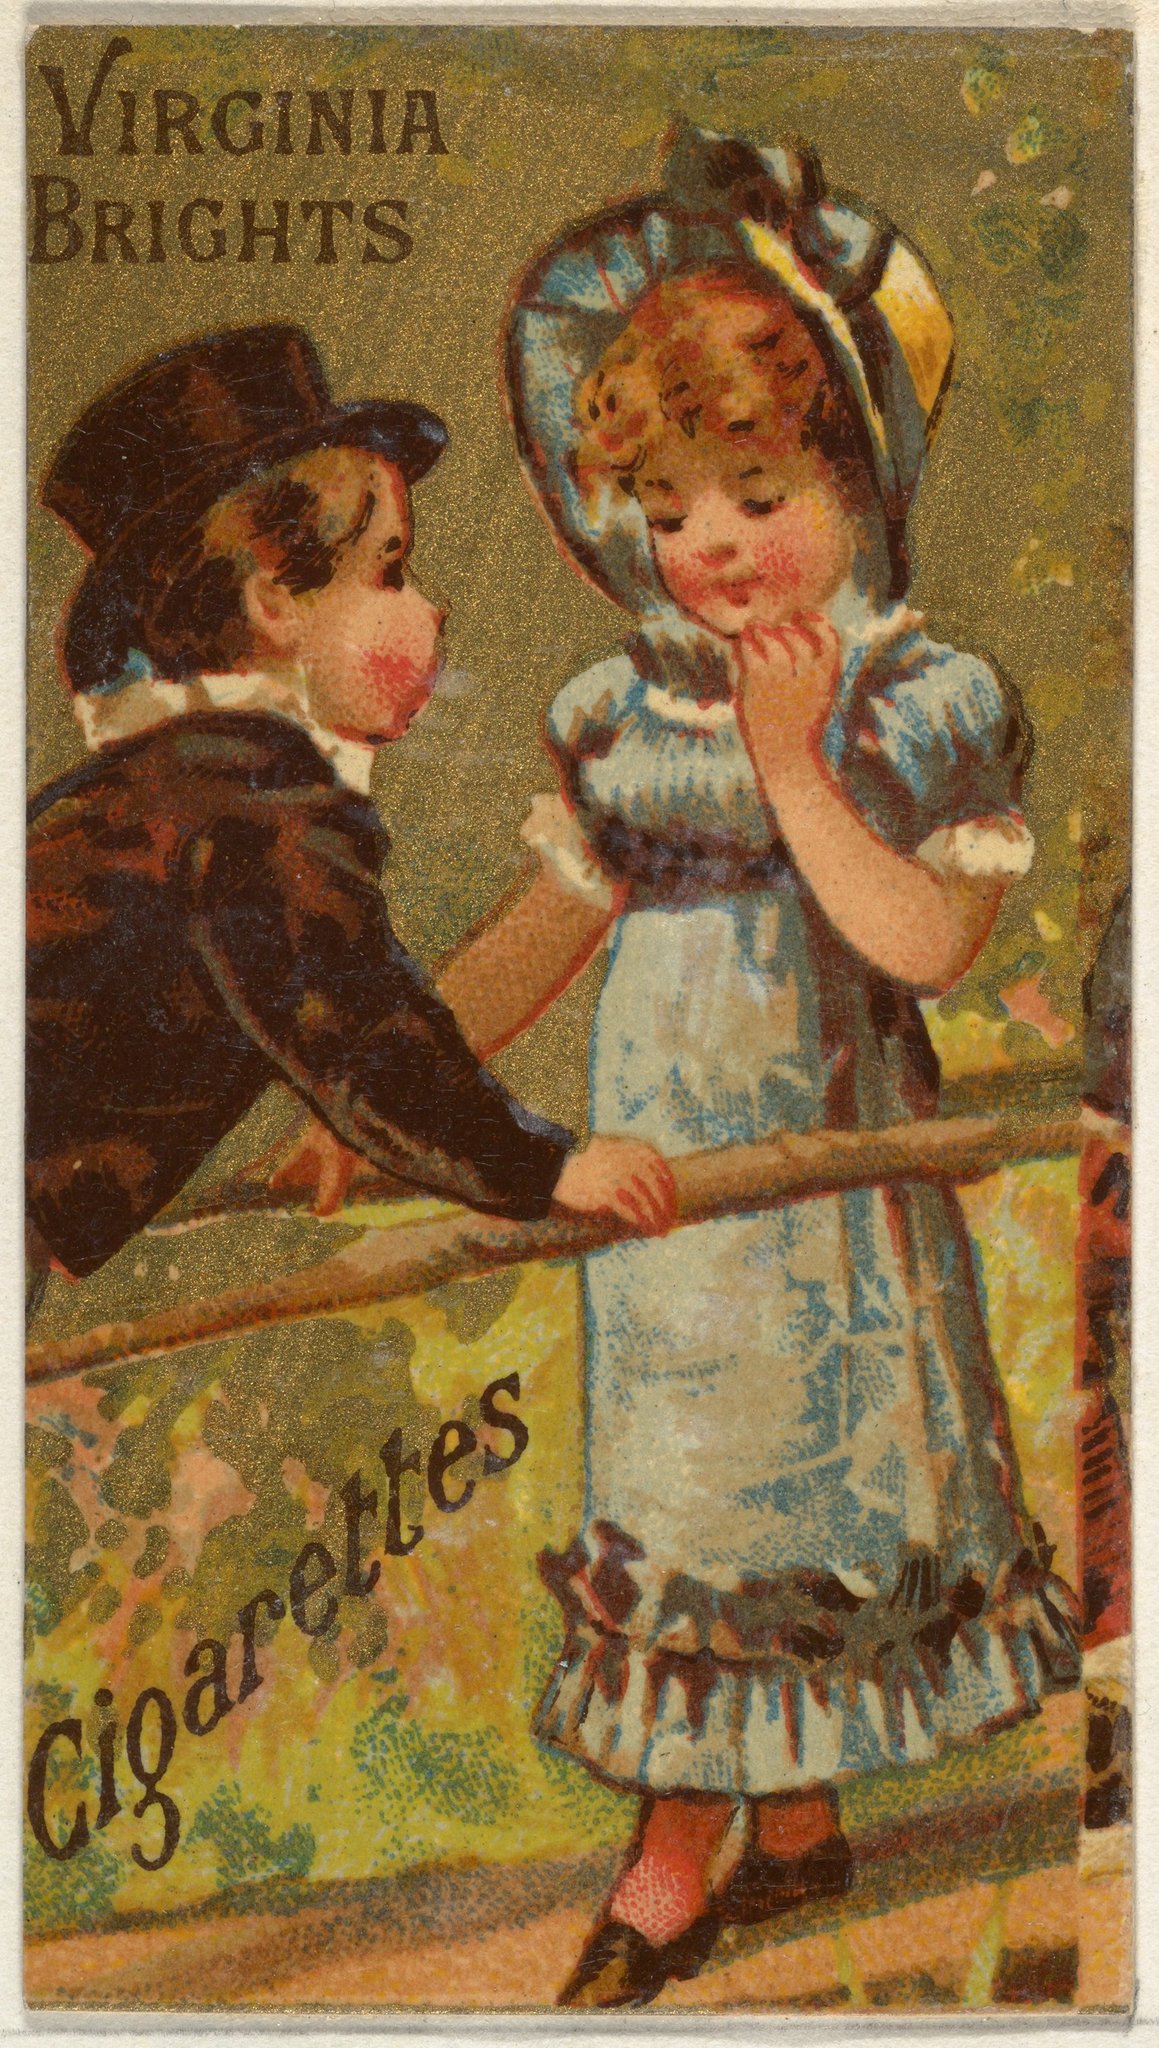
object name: print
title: From the Girls and Children series (N64) promoting Virginia Brights Cigarettes for Allen & Ginter brand tobacco products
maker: allen & ginter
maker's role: publisher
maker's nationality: american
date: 1886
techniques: color lithograph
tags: boys,girls